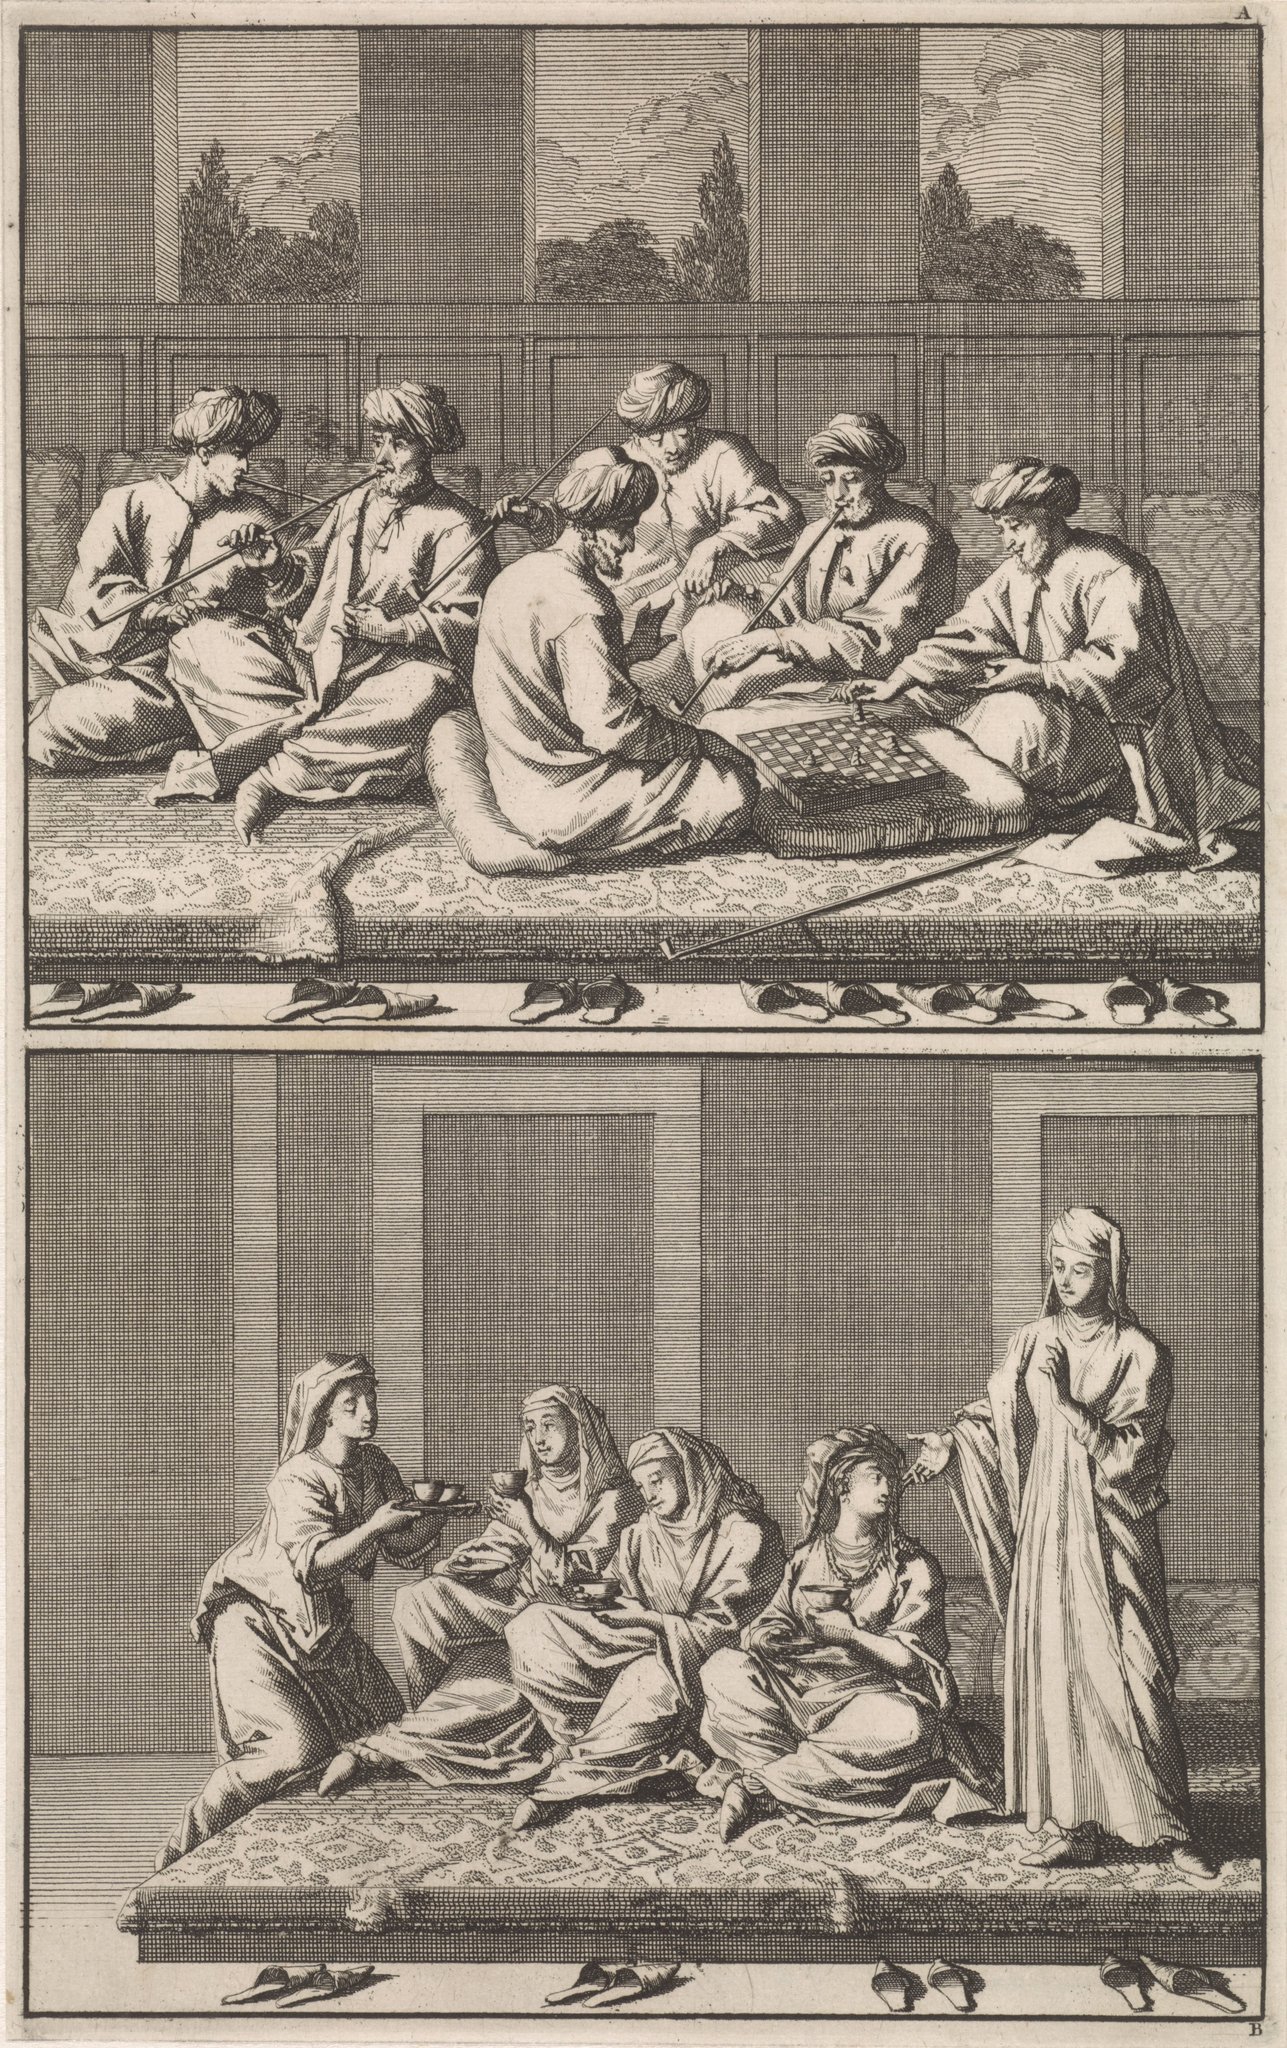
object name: print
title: Gezelschap van zes rokende en schaakspelende Turken / Gezelschap van vier koffiedrinkende vrouwen en een tot slaaf gemaakte bediende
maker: jan luyken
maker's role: draughtsman, print maker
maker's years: 1649-1712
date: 1698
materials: paper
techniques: engraving, etching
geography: amsterdam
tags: master ~ enslaved person, asiatic races and peoples: turks, chess, pipe ~ tobacco, slavery; serfs and enslaved persons, cup of coffee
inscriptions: collector's mark: Lugt 2228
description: Gebruikt als illustratie in: Bruyn, Cornelis. Reizen van Cornelis de Bruyn, door de vermaardste deelen van Klein Asia. Delft: Hendrik van Kroonevelt, 1698, p. 136.